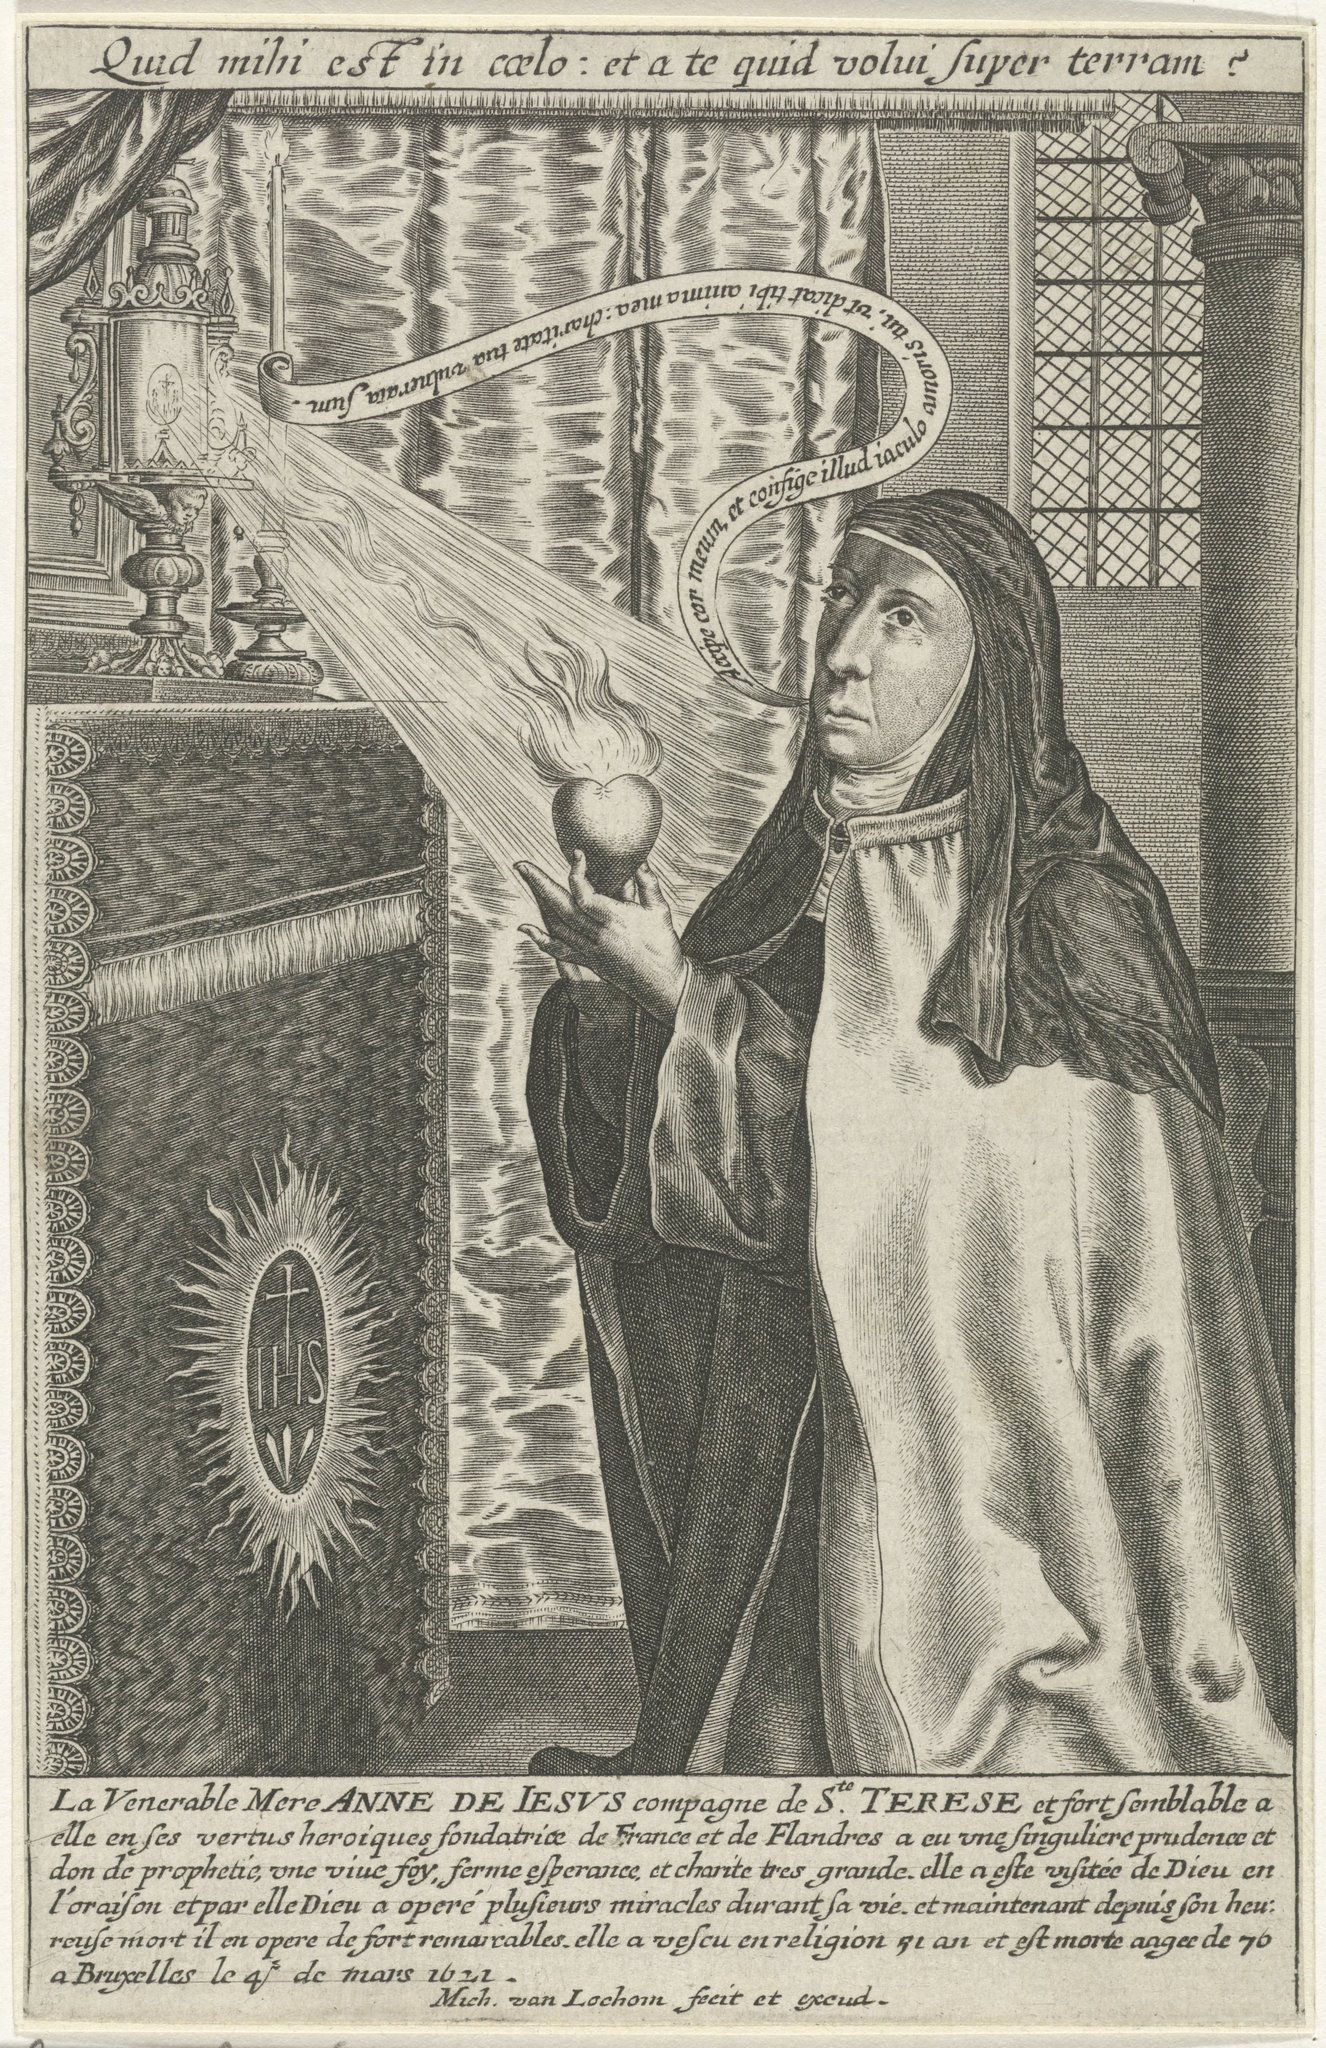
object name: print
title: Anna van Jezus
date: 1611-1647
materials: paper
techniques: engraving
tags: ostensorium, monstrance, specific types of crucified christ (in non-narrative context), monastic orders, monastic life ~ roman catholic church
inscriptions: collector's mark: Lugt 2228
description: De karmelietes Anna van Jezus is met een brandend hart in haar handen geknield voor een monstrans op een altaar. Ze wordt beschenen door een bundel licht, afkomstig van de gekruisigde Christus die in de monstrans is afgebeeld.